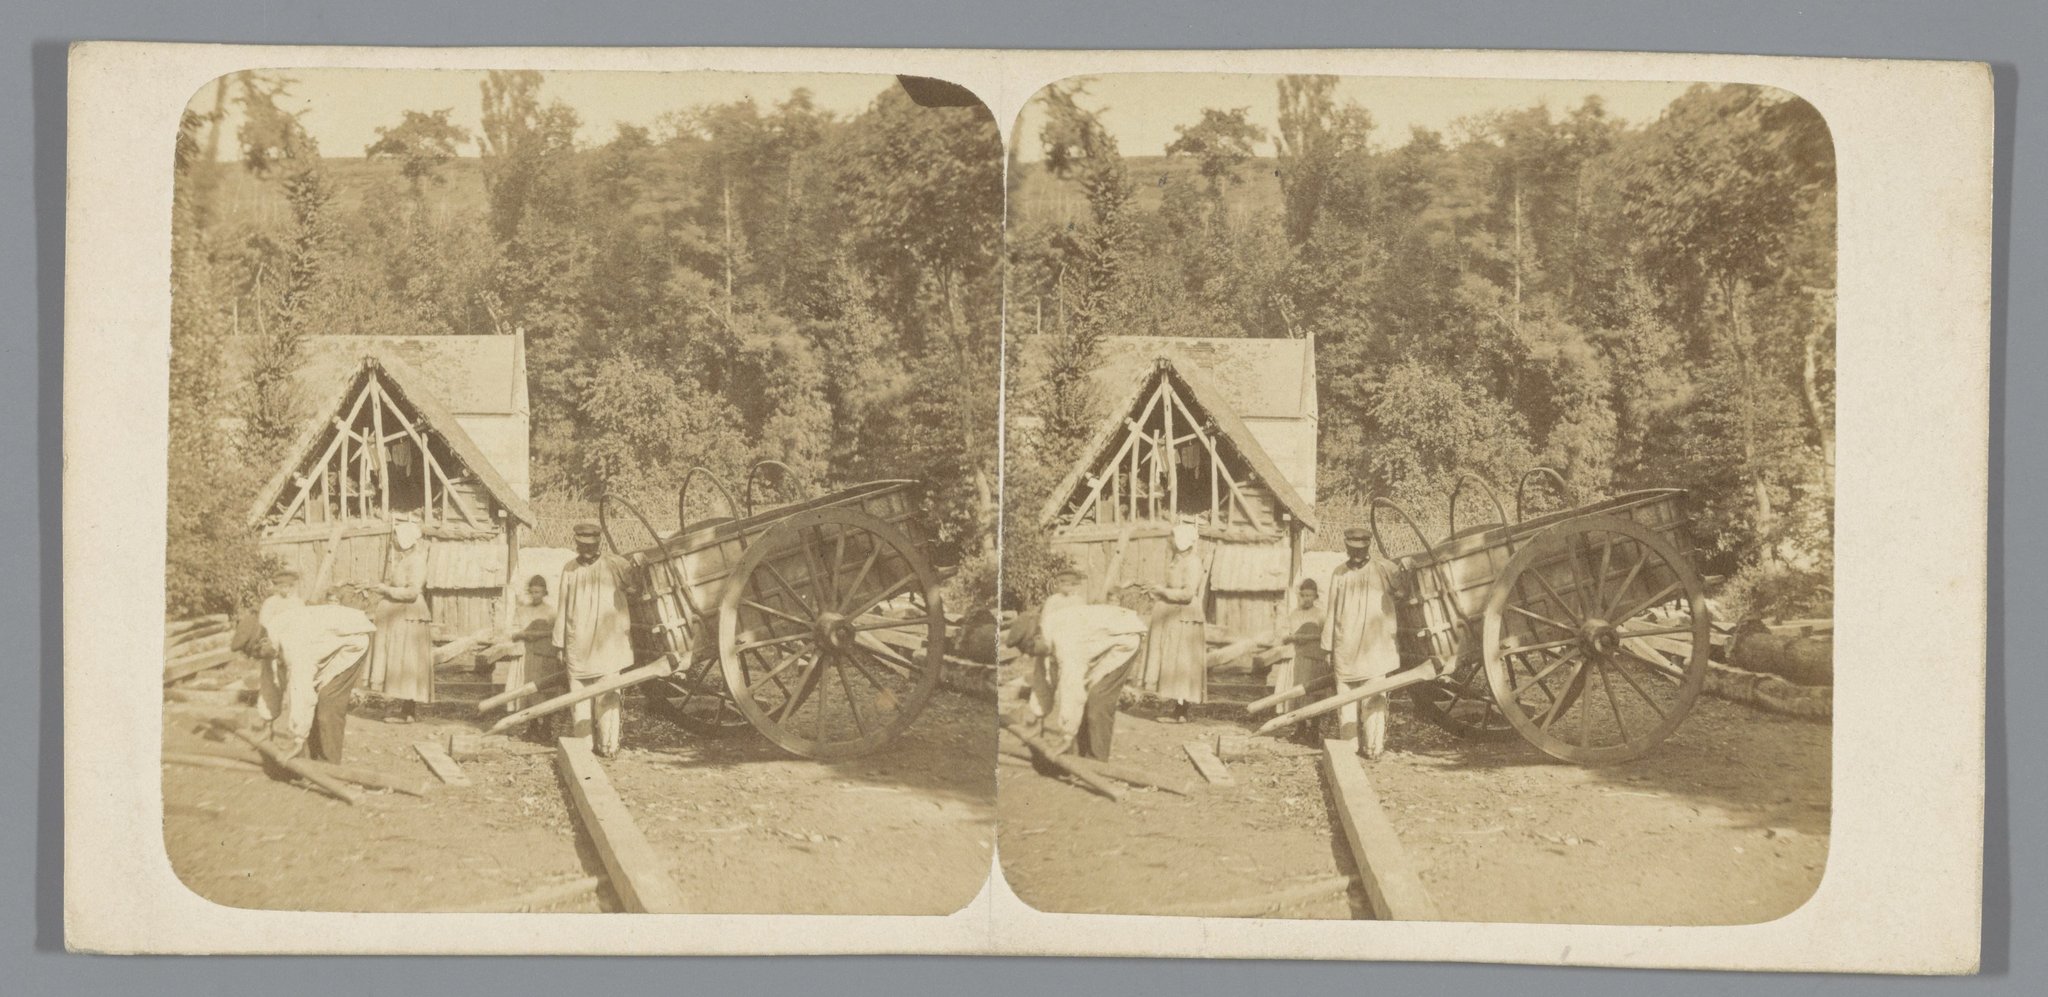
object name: stereograph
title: Personen naast een houten kar te Normandië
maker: Anonymous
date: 1860-1880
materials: cardboard, photographic support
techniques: albumen print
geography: normandy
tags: (farm) wagon, freight wagon, cart, historical persons not known by name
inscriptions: number: ‘41’, inscription: ‘Interieur Normande’